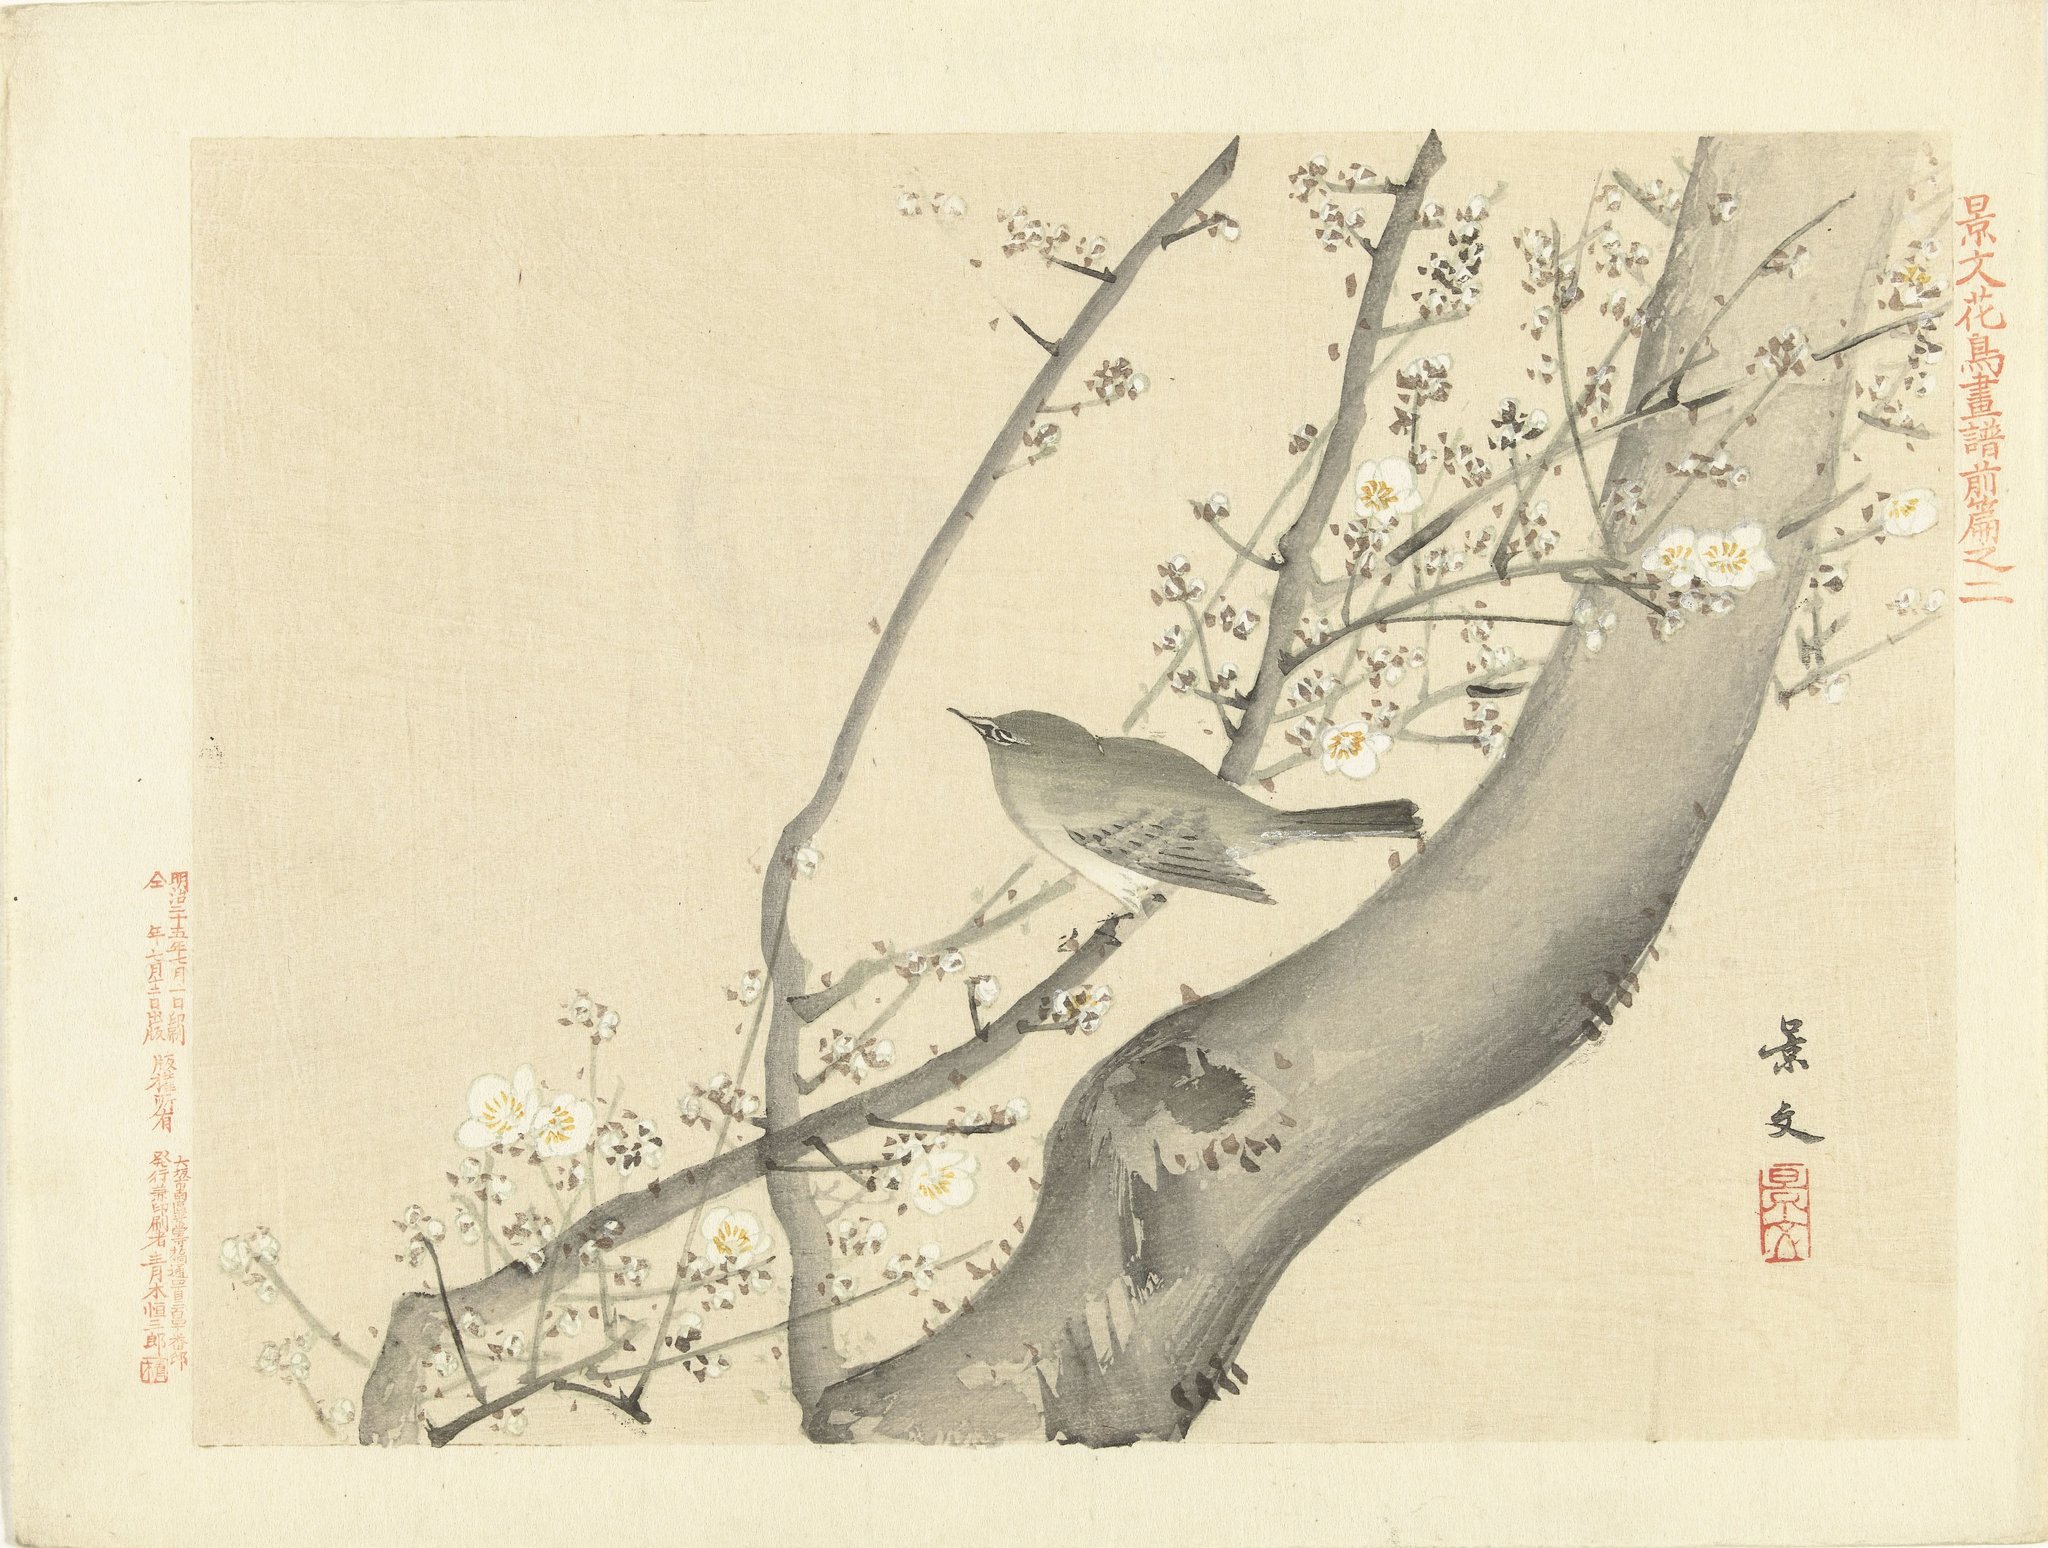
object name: print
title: Bloemen- en vogelschetsen van Keibun- deel één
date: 1807-1892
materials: paper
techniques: woodcut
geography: osaka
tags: plants; vegetation, birds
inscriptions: collector's mark: Lugt 2228, collector's mark: ‘Rijksschool voor kunstnijverheid’ Lugt 3937